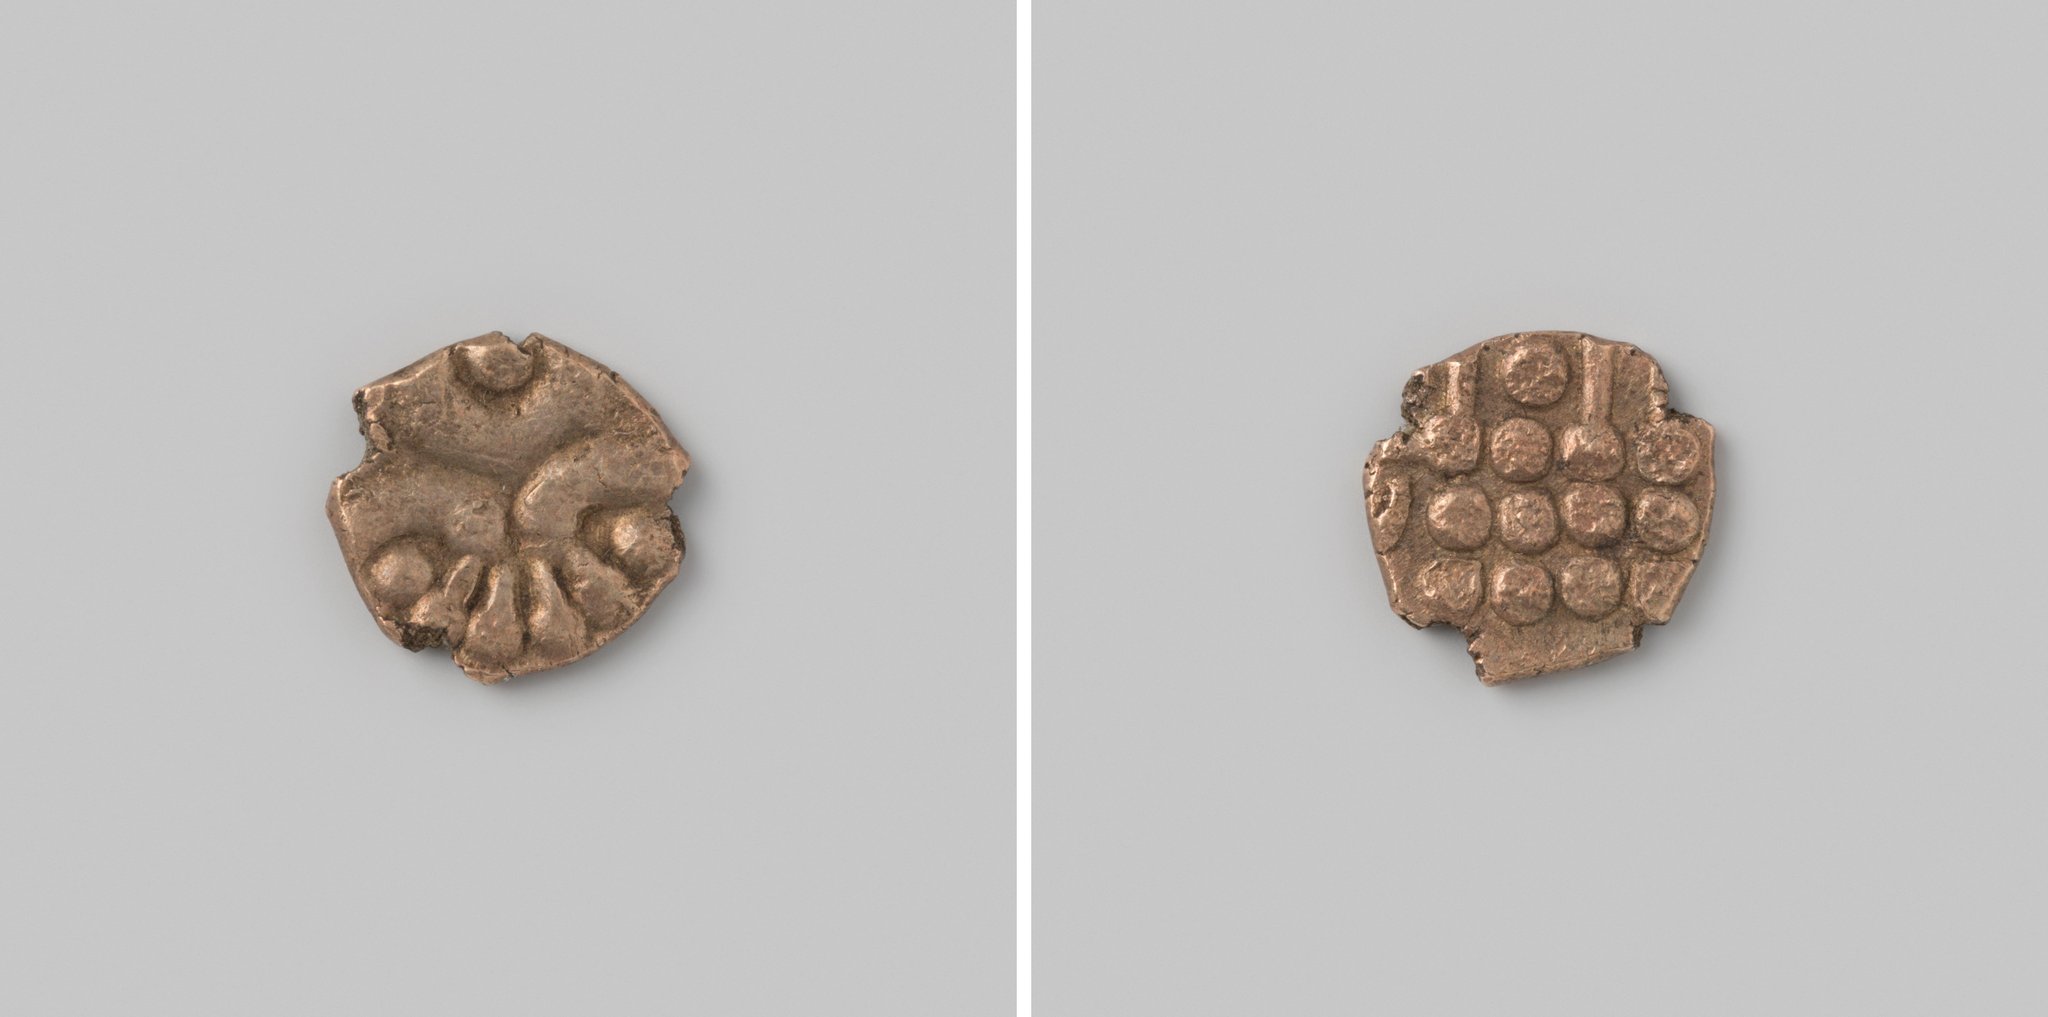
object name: gouden fanam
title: Gouden fanam uit Tinnevelli in India onder de Nayakas,1520-1736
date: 1520-1736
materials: gold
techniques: striking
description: Gouden munt. Voorzijde: aanziende godheid [?]. Keerzijde: versiering, waaronder drie rijen van elk vier stippen.